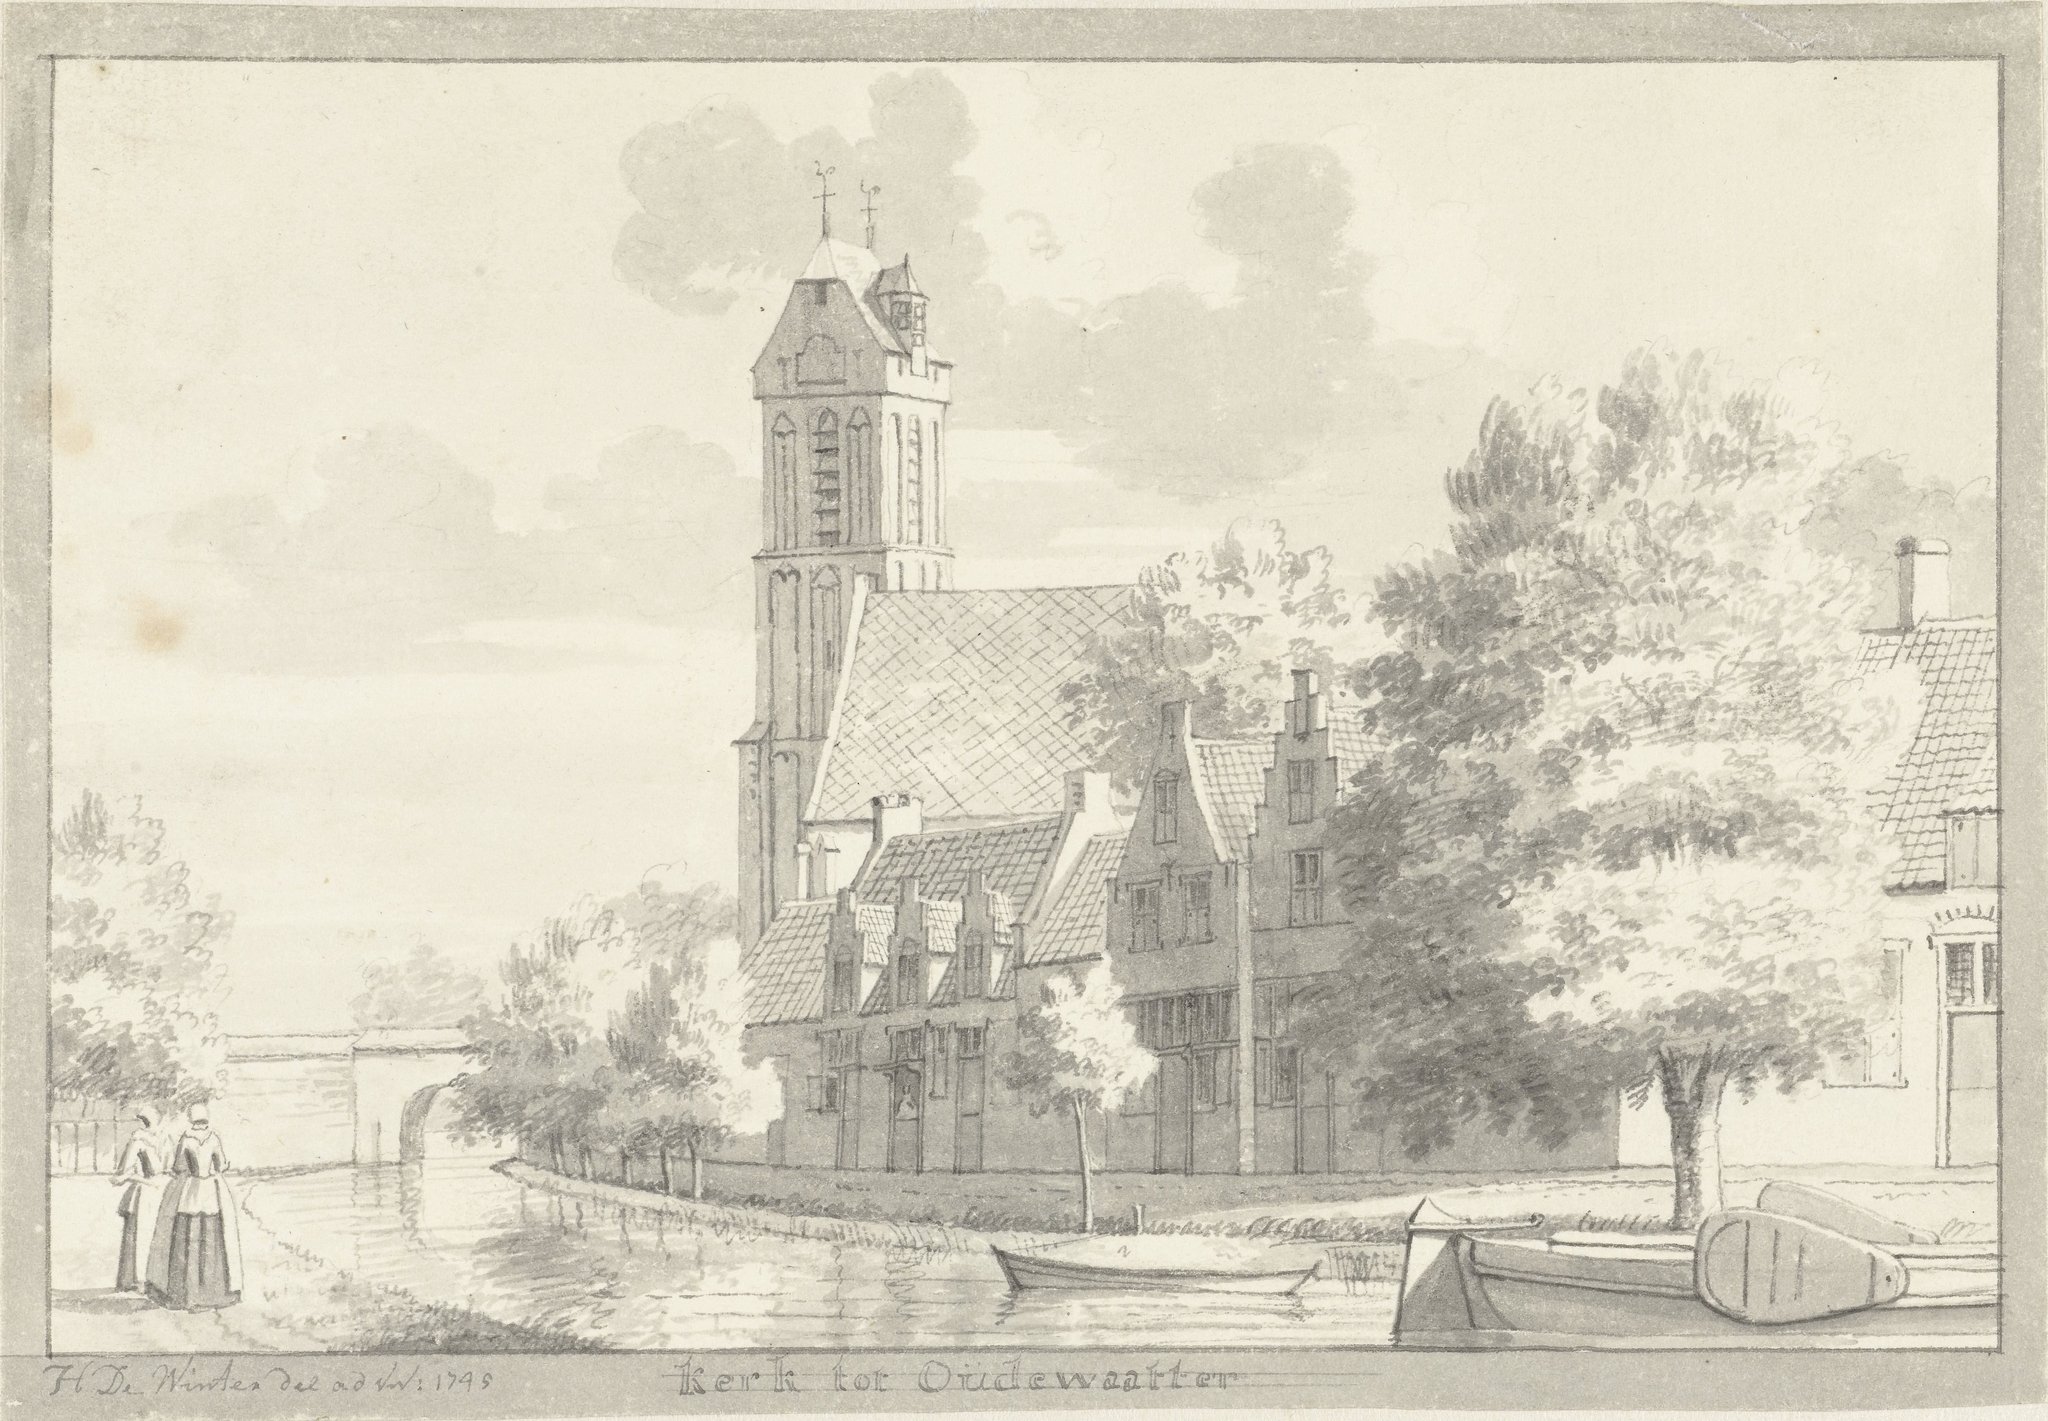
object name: drawing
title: Kerk tot Oudewaatter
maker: hendrik de winter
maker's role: draughtsman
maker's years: 1717-1790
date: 1745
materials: ink, paper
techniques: brush, pen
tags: church (exterior)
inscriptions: inscription: ‘H de Winter Del: ad viv: 1745 Kerk tot Oudewaatter’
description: Voor prent gebaseerd op deze tekening zie RP-P-AO-10-65A-7.